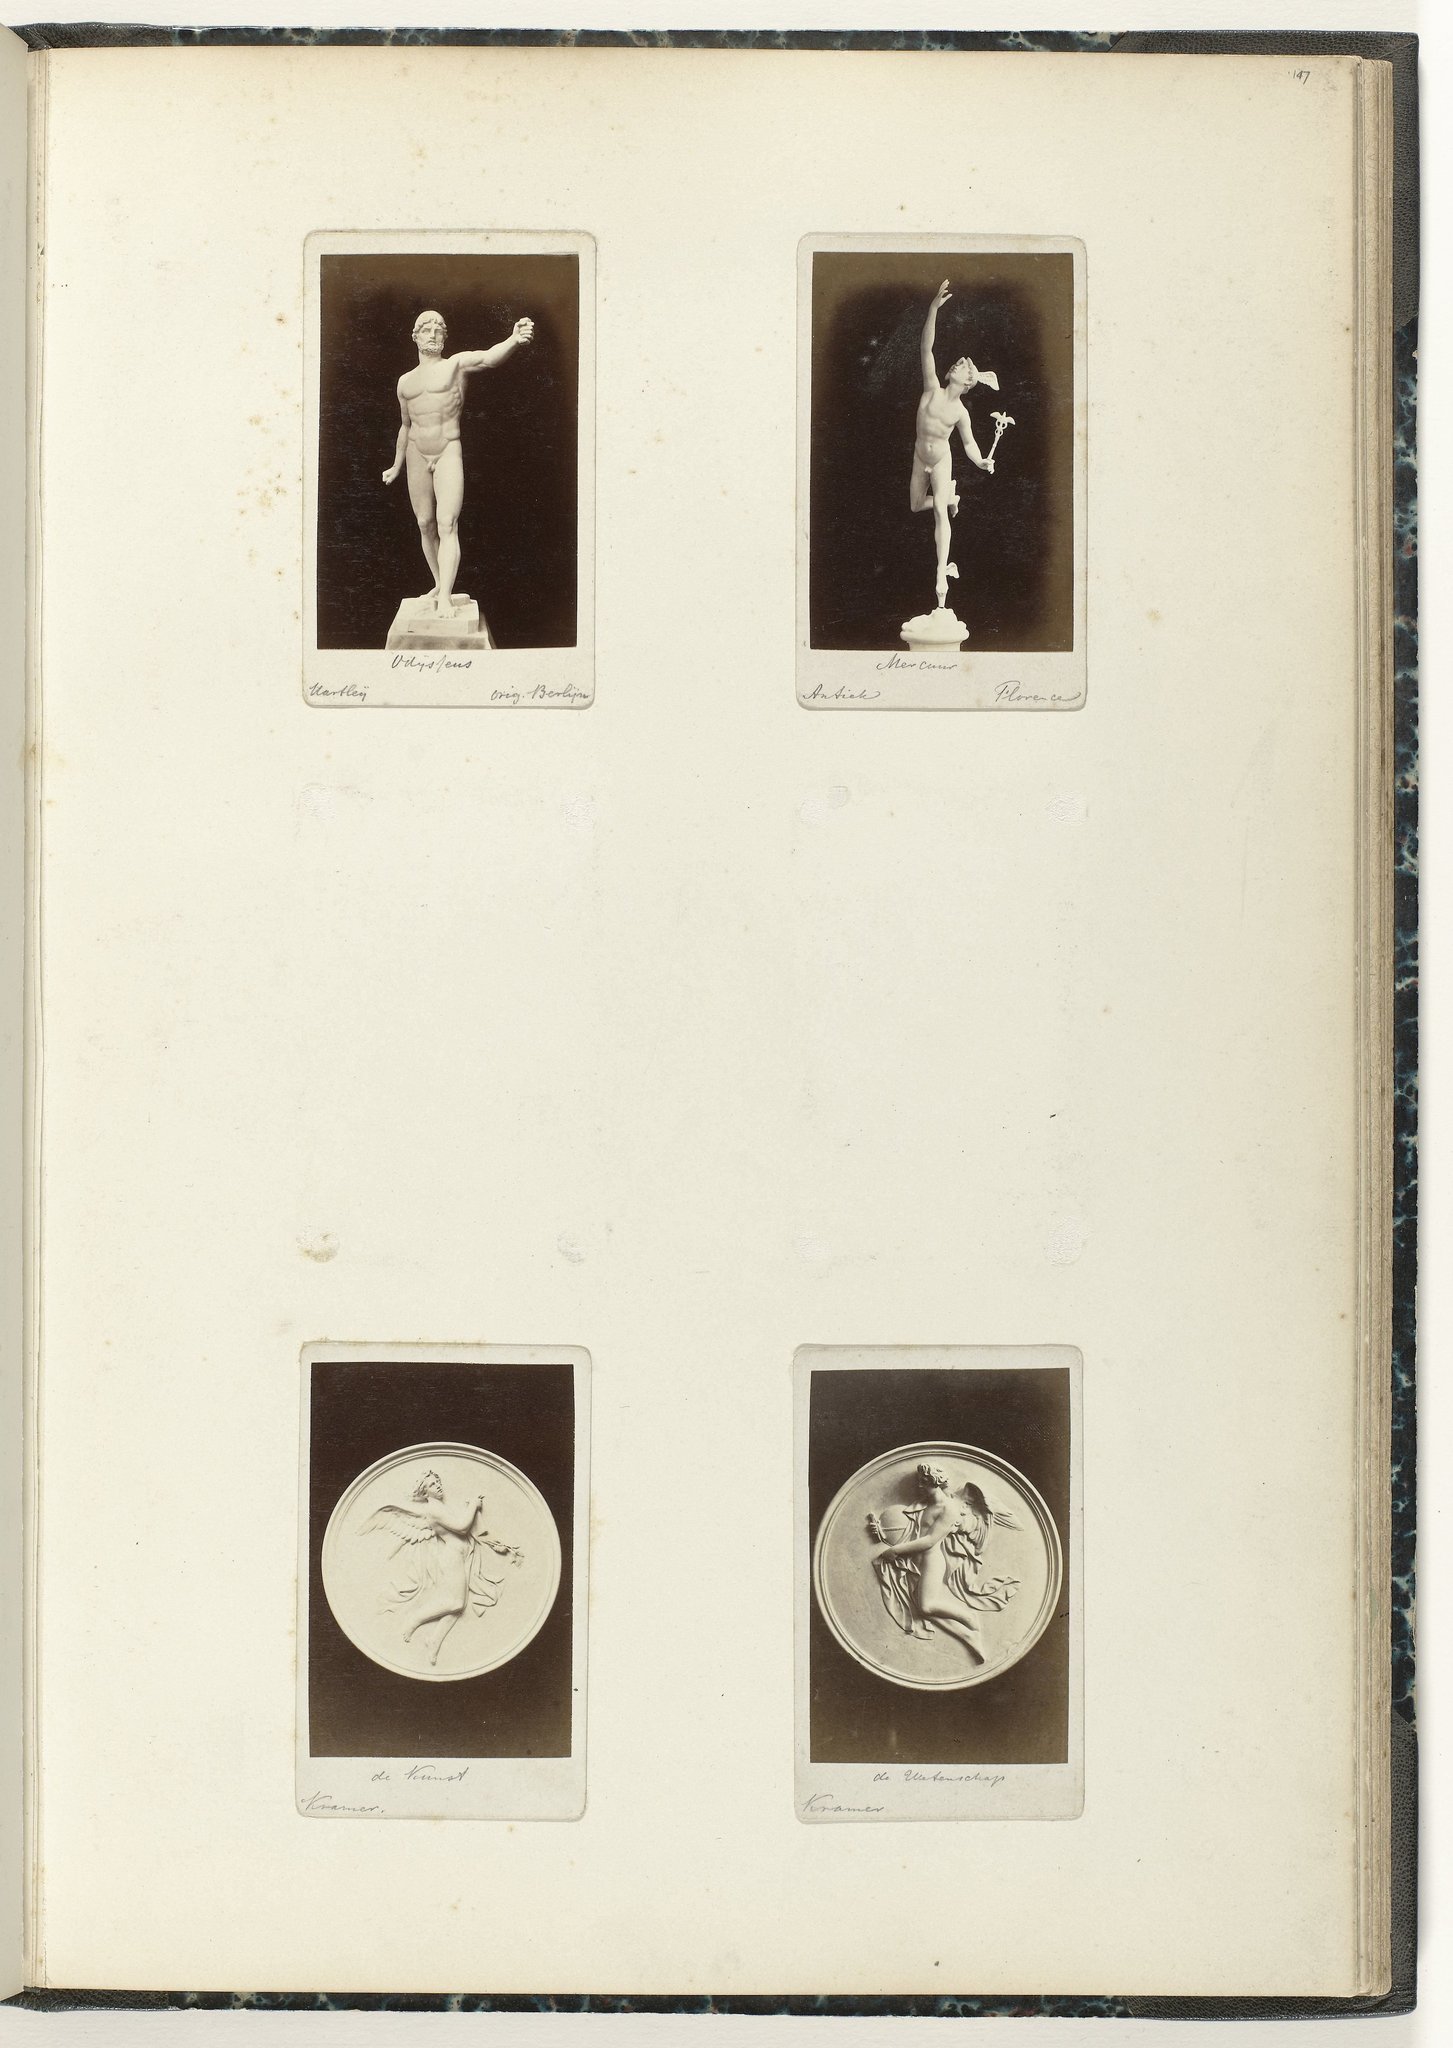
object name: carte de visite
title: Vier cartes-de-visite met beelden en medaillons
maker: Anonymous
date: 1866-1900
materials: cardboard, paper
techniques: albumen print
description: Twee beelden van Odysseus en Mercurius op sokkels en twee medaillons met de Kunst en de Wetenschap. Onderaan de cartes-de-visite staat met potlood geschreven wat er afgebeeld is; onder de foto linksboven staat de naam Hartleij, onder de foto's onderaan de naam Kramer.